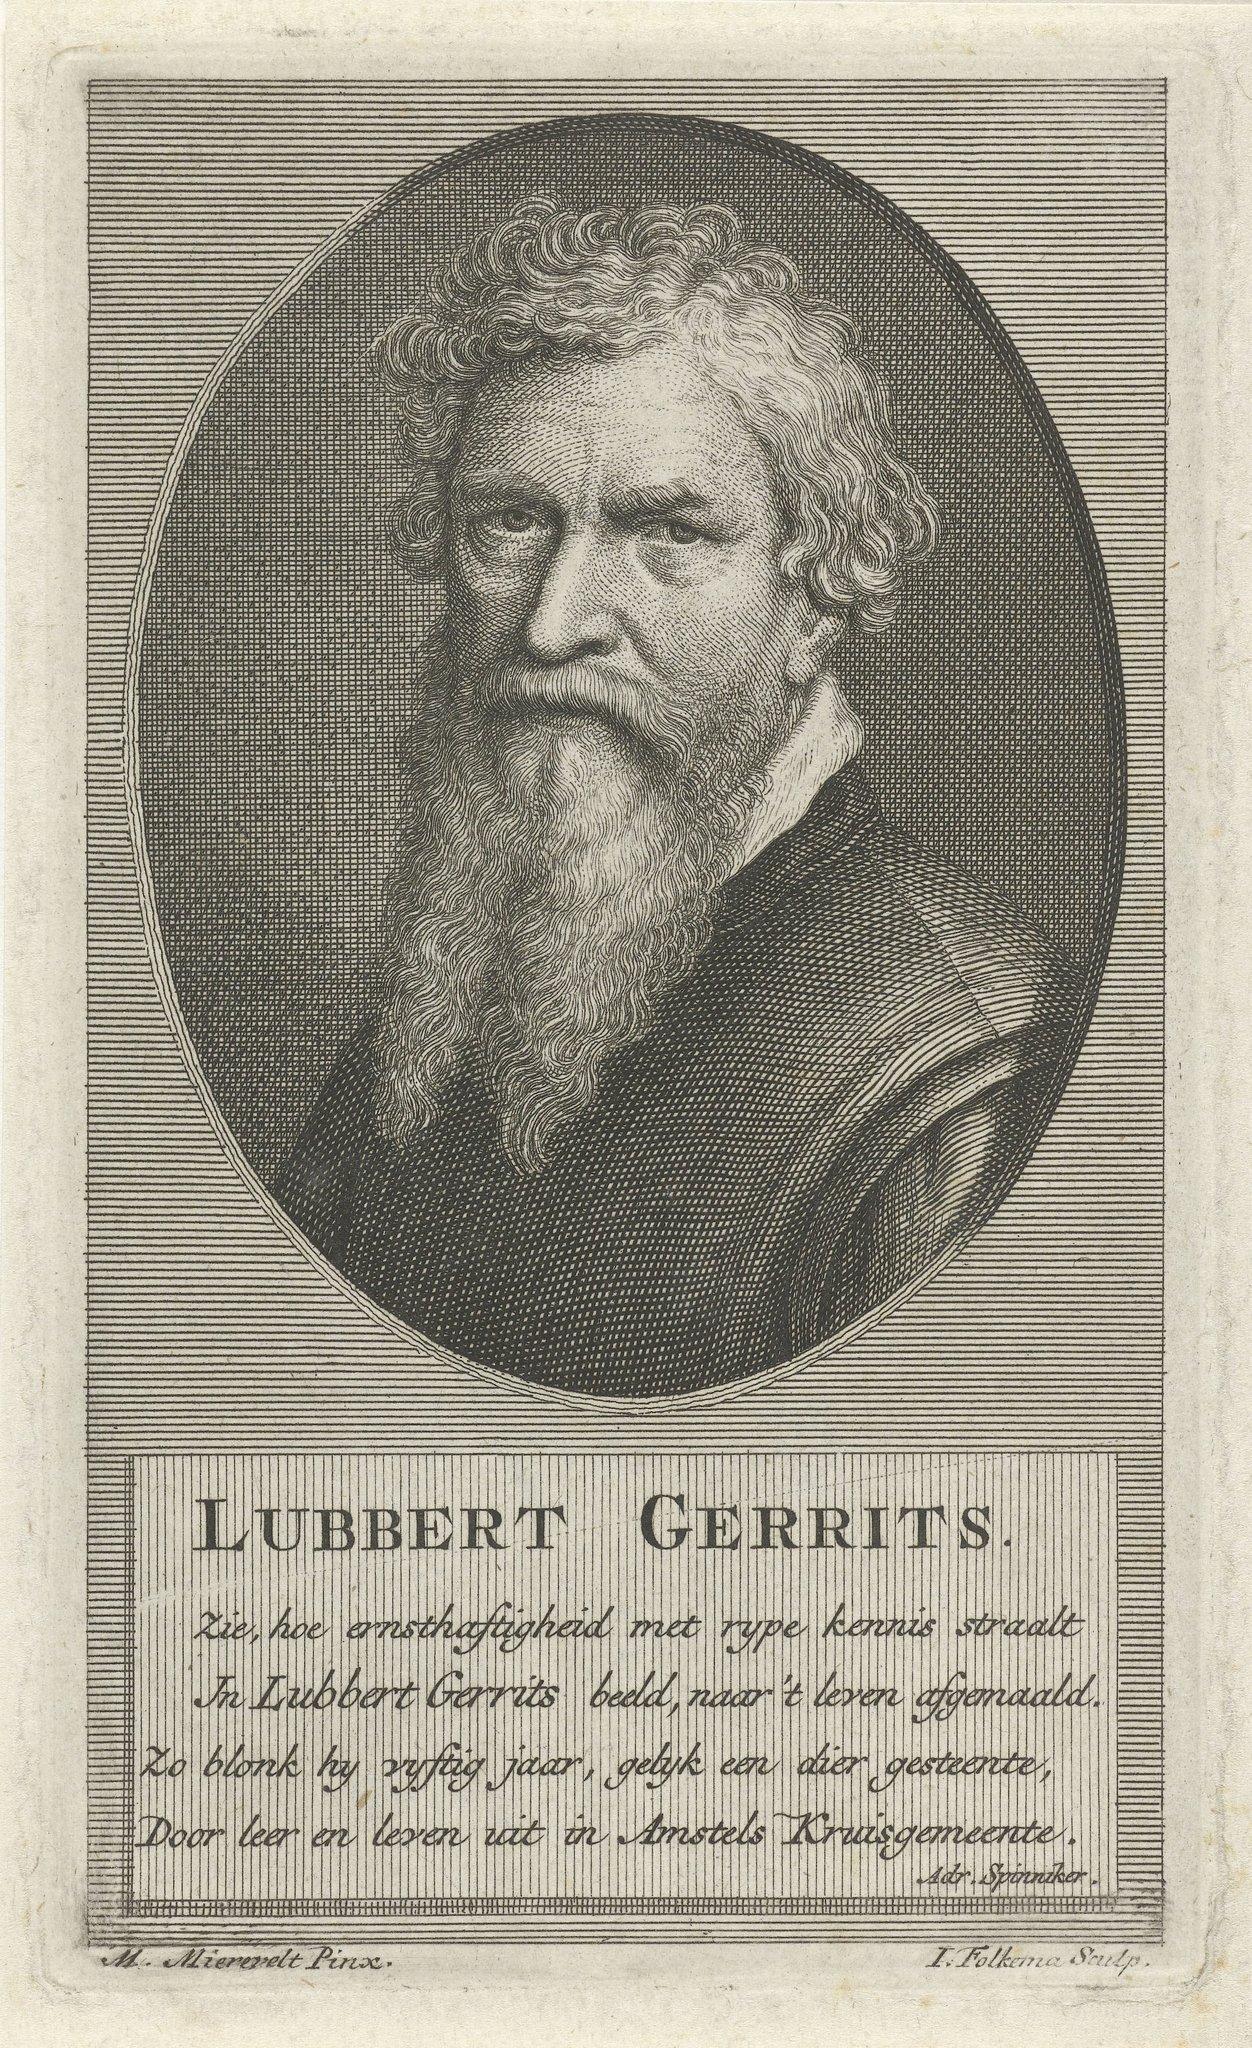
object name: print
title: Portret van Lubbert Gerrits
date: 1702-1767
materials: paper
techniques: engraving, etching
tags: predikant, lubbert gerrits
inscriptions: collector's mark: Lugt 2228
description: Portretbuste in ovaal naar links van predikant Lubbert Gerrits, blootshoofds. Onder het portret staan de naam van de geportretteerde en een vierregelig vers in het Nederlands.